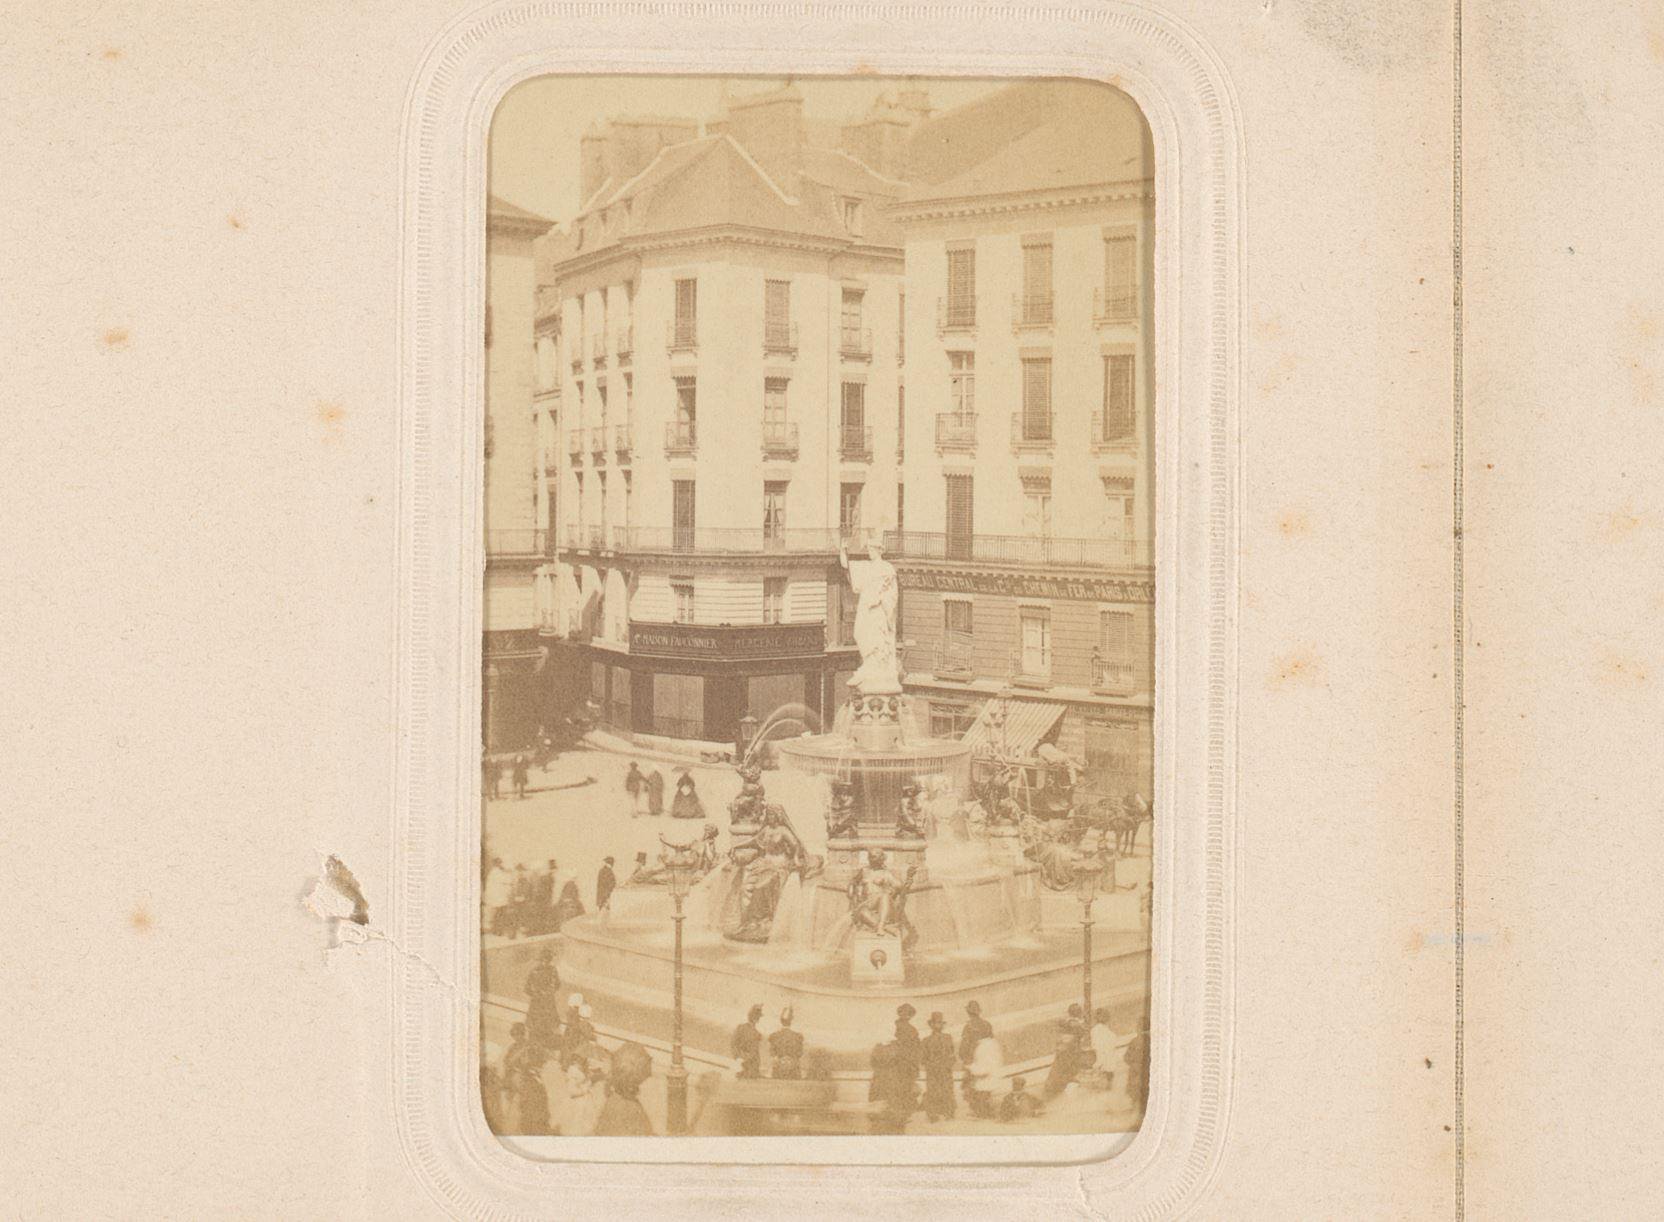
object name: album leaf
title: Gezicht op een plein met fontein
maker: j. trésorier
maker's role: fotograaf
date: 1860-1900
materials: cardboard, photographic support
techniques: albumen print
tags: square, place, circus, etc., city-view in general; 'veduta', ornamental fountain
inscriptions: inscription: ‘J. Trésorier/ Rue du Chapeau rouge 6/ et Rue Coileau 16 (bis)/ dans le jardin’